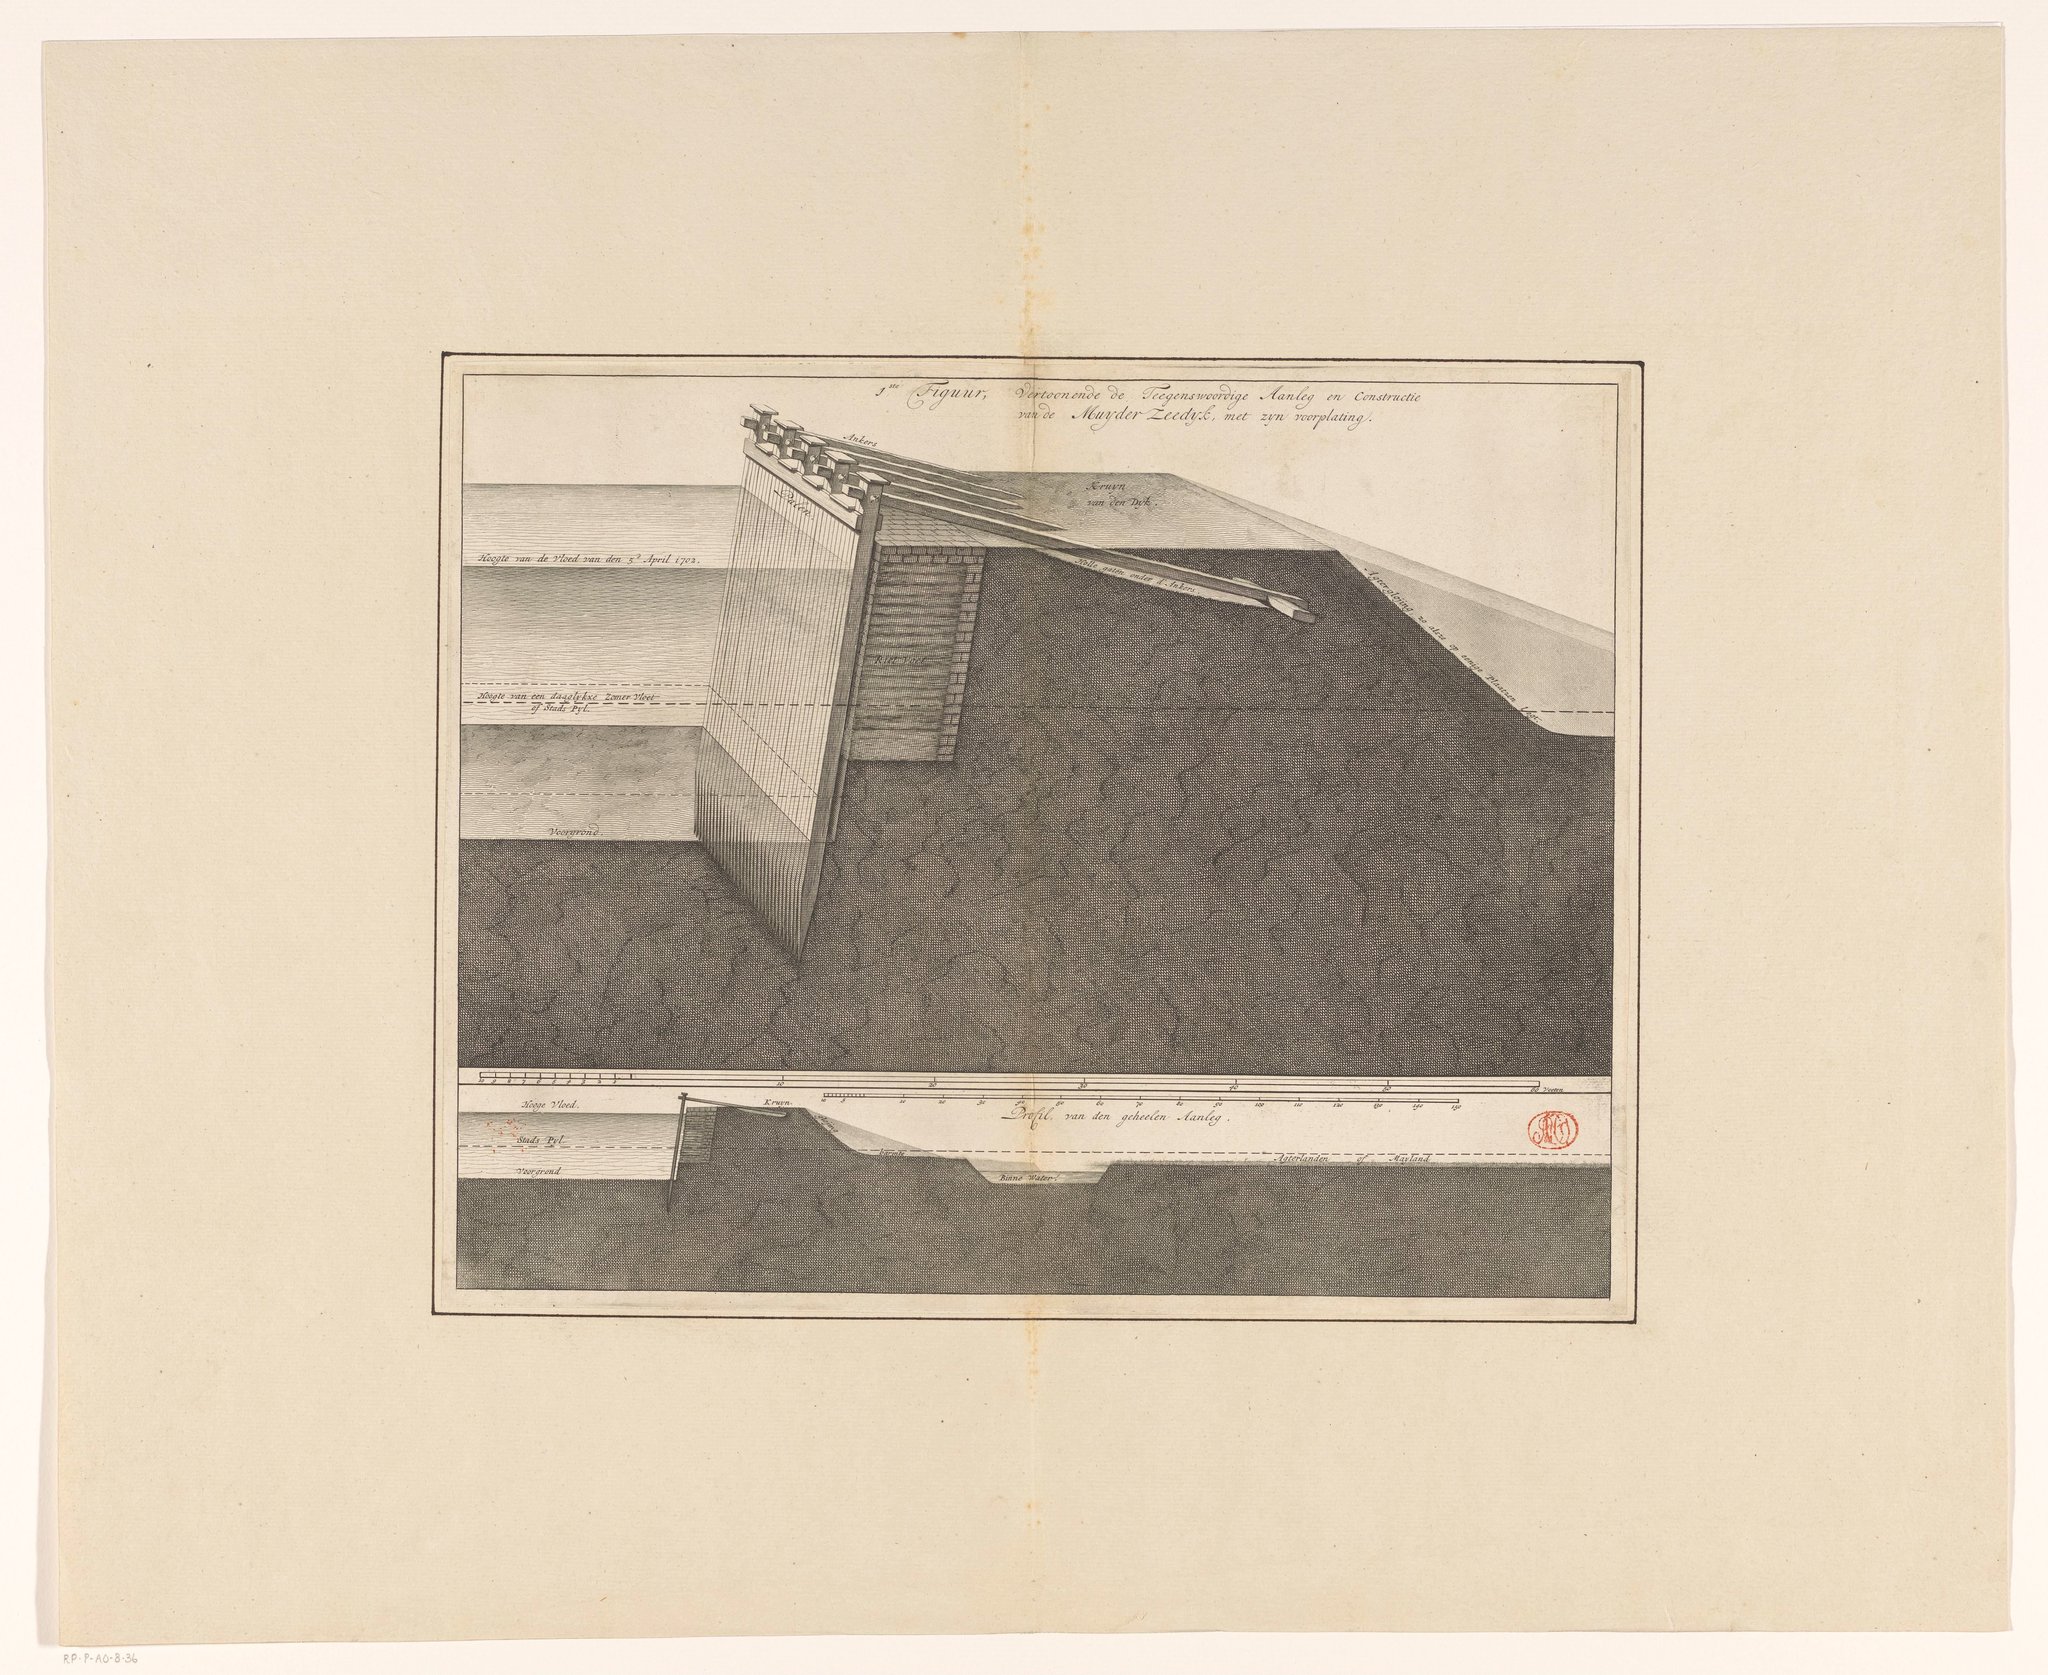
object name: print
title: Twee profielen van de zeedijk ten oosten van Muiden, 1703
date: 1703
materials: paper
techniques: engraving, etching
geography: amsterdam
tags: dikes, levee, amsterdam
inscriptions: collector's mark: Lugt 195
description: Prent gebruikt in: Heyden, Jan van der (de Jonge). Berigt nopende den toestand van de zeedyk, tussen Amsterdam en Muyden, volgens ordre van de edele groot achtbare heeren burgemeesteren en regeerders der stad Amsterdam, (…). Amsterdam: s.n., s.a. [1703]. Zie RP-P-AO-8-35, RP-P-AO-8-36X en RP-P-AO-8-37 voor andere prenten uit deze publicatie. Zie RP-P-AO-8-35A en RP-P-AO-8-37B voor prenten over de later uitgevoerde verstevigingen van de dijk.